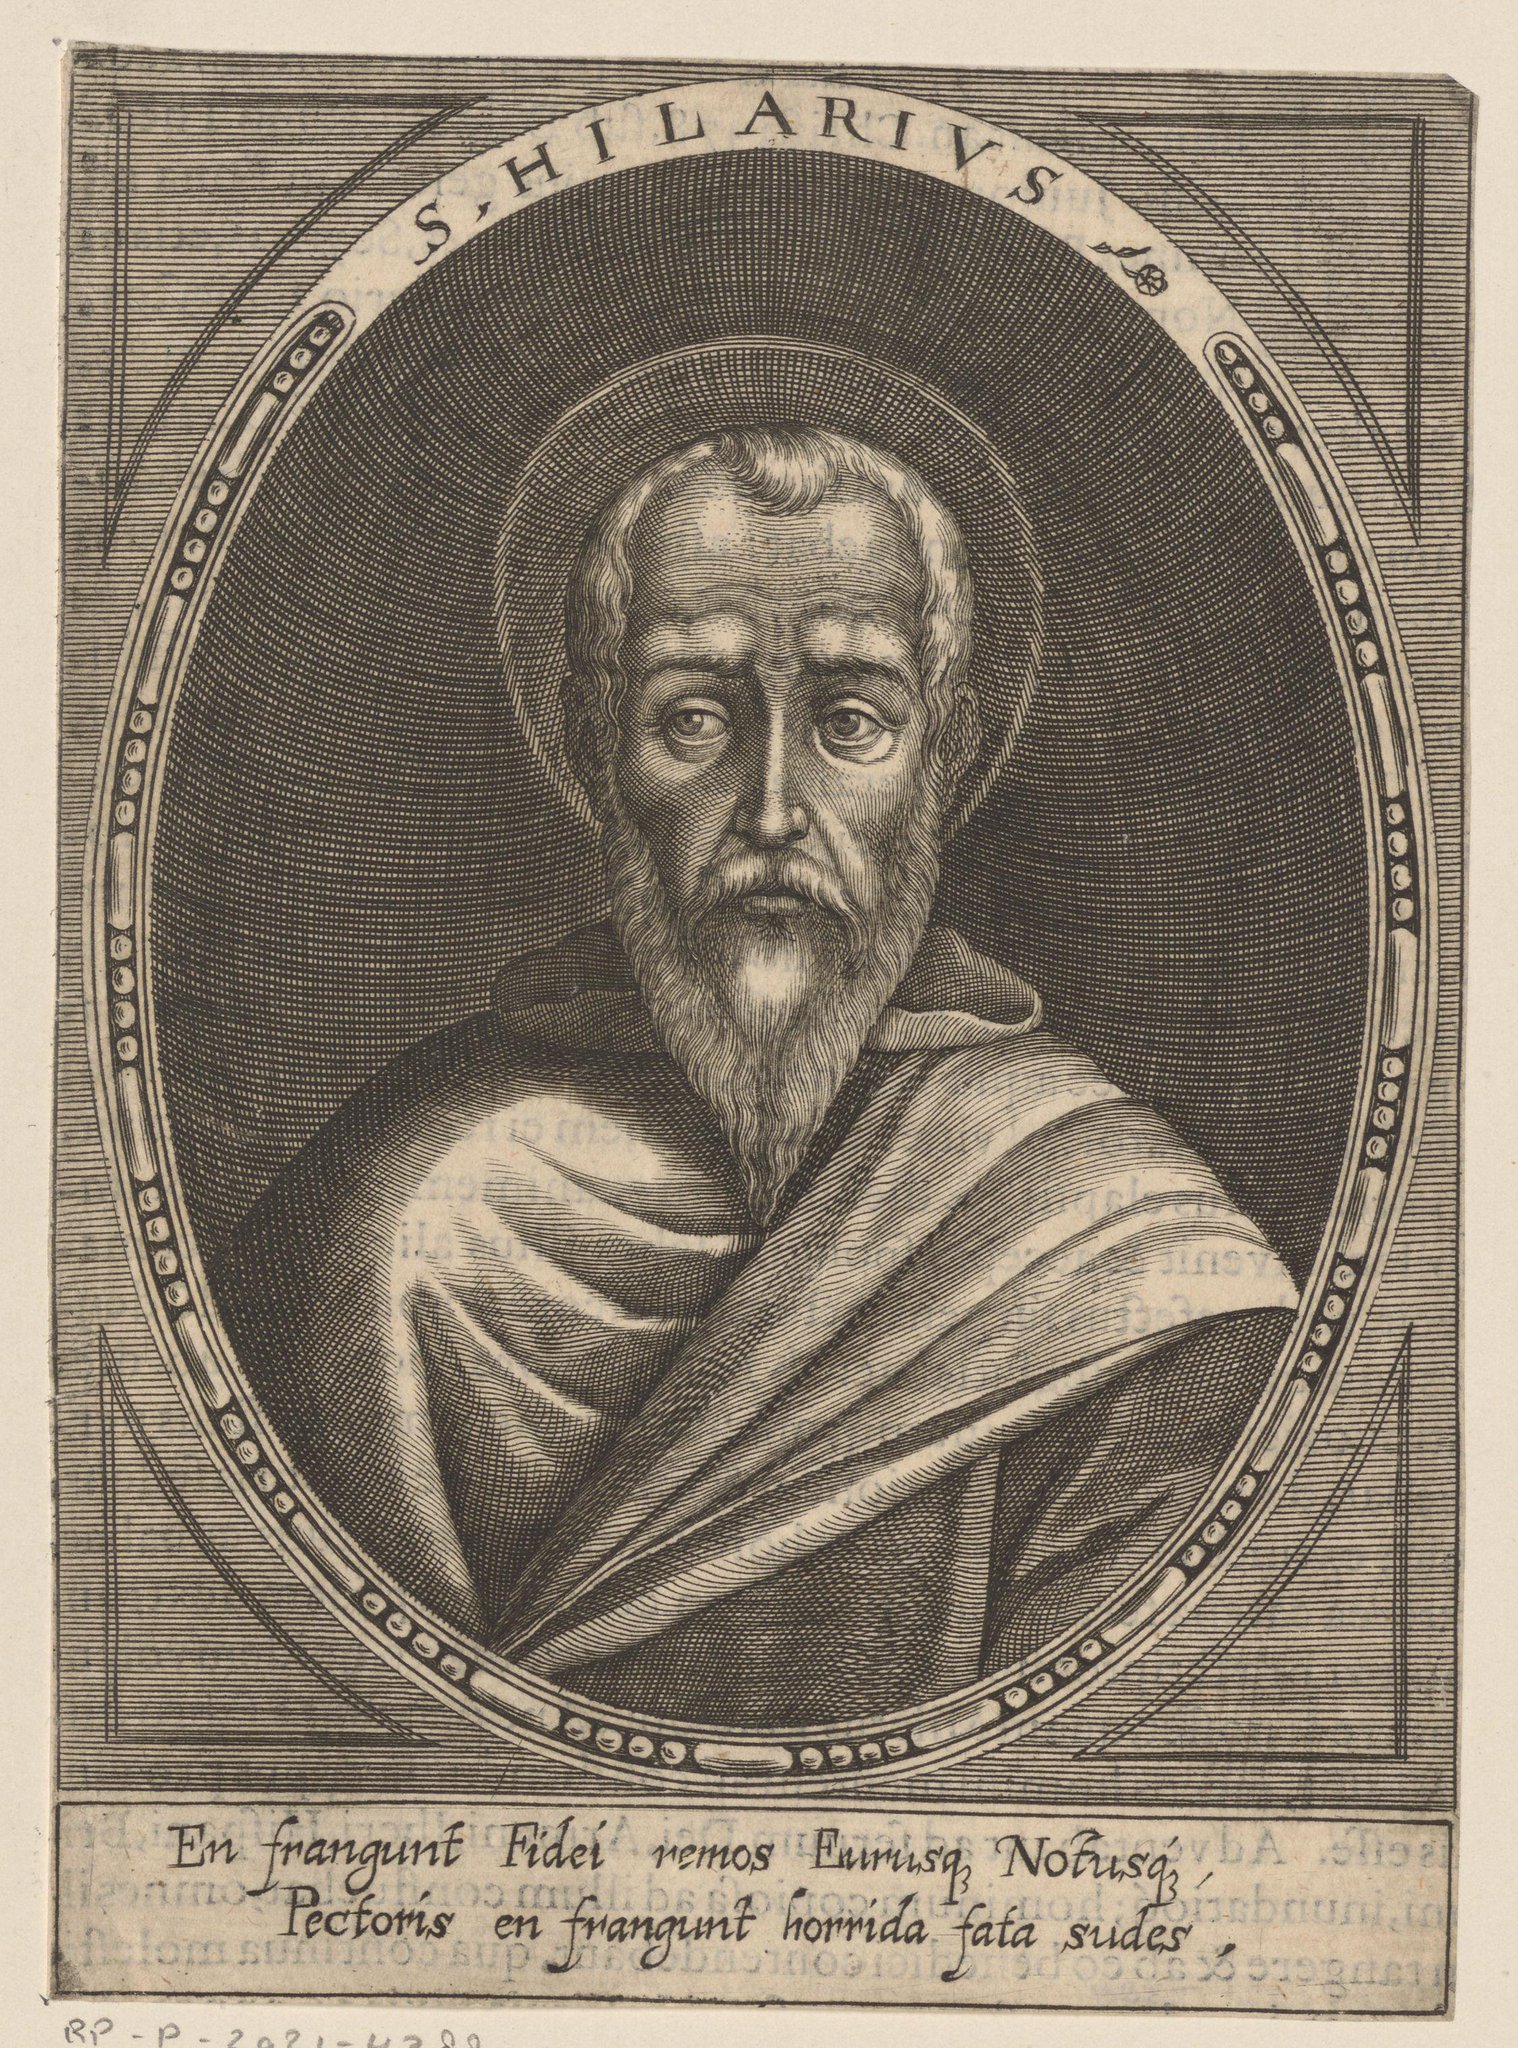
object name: print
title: Portret van paus Hilarius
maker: raphael custos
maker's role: print maker, publisher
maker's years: 1590-1664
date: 1624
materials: paper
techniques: engraving, letterpress printing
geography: augsburg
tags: historical persons, pope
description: Prent uit: Custos, Raphael. Patrologia, id est descriptio S. patrum Graecorum & Latinorum (...). Augsburg: Raphael Custos, 1624.